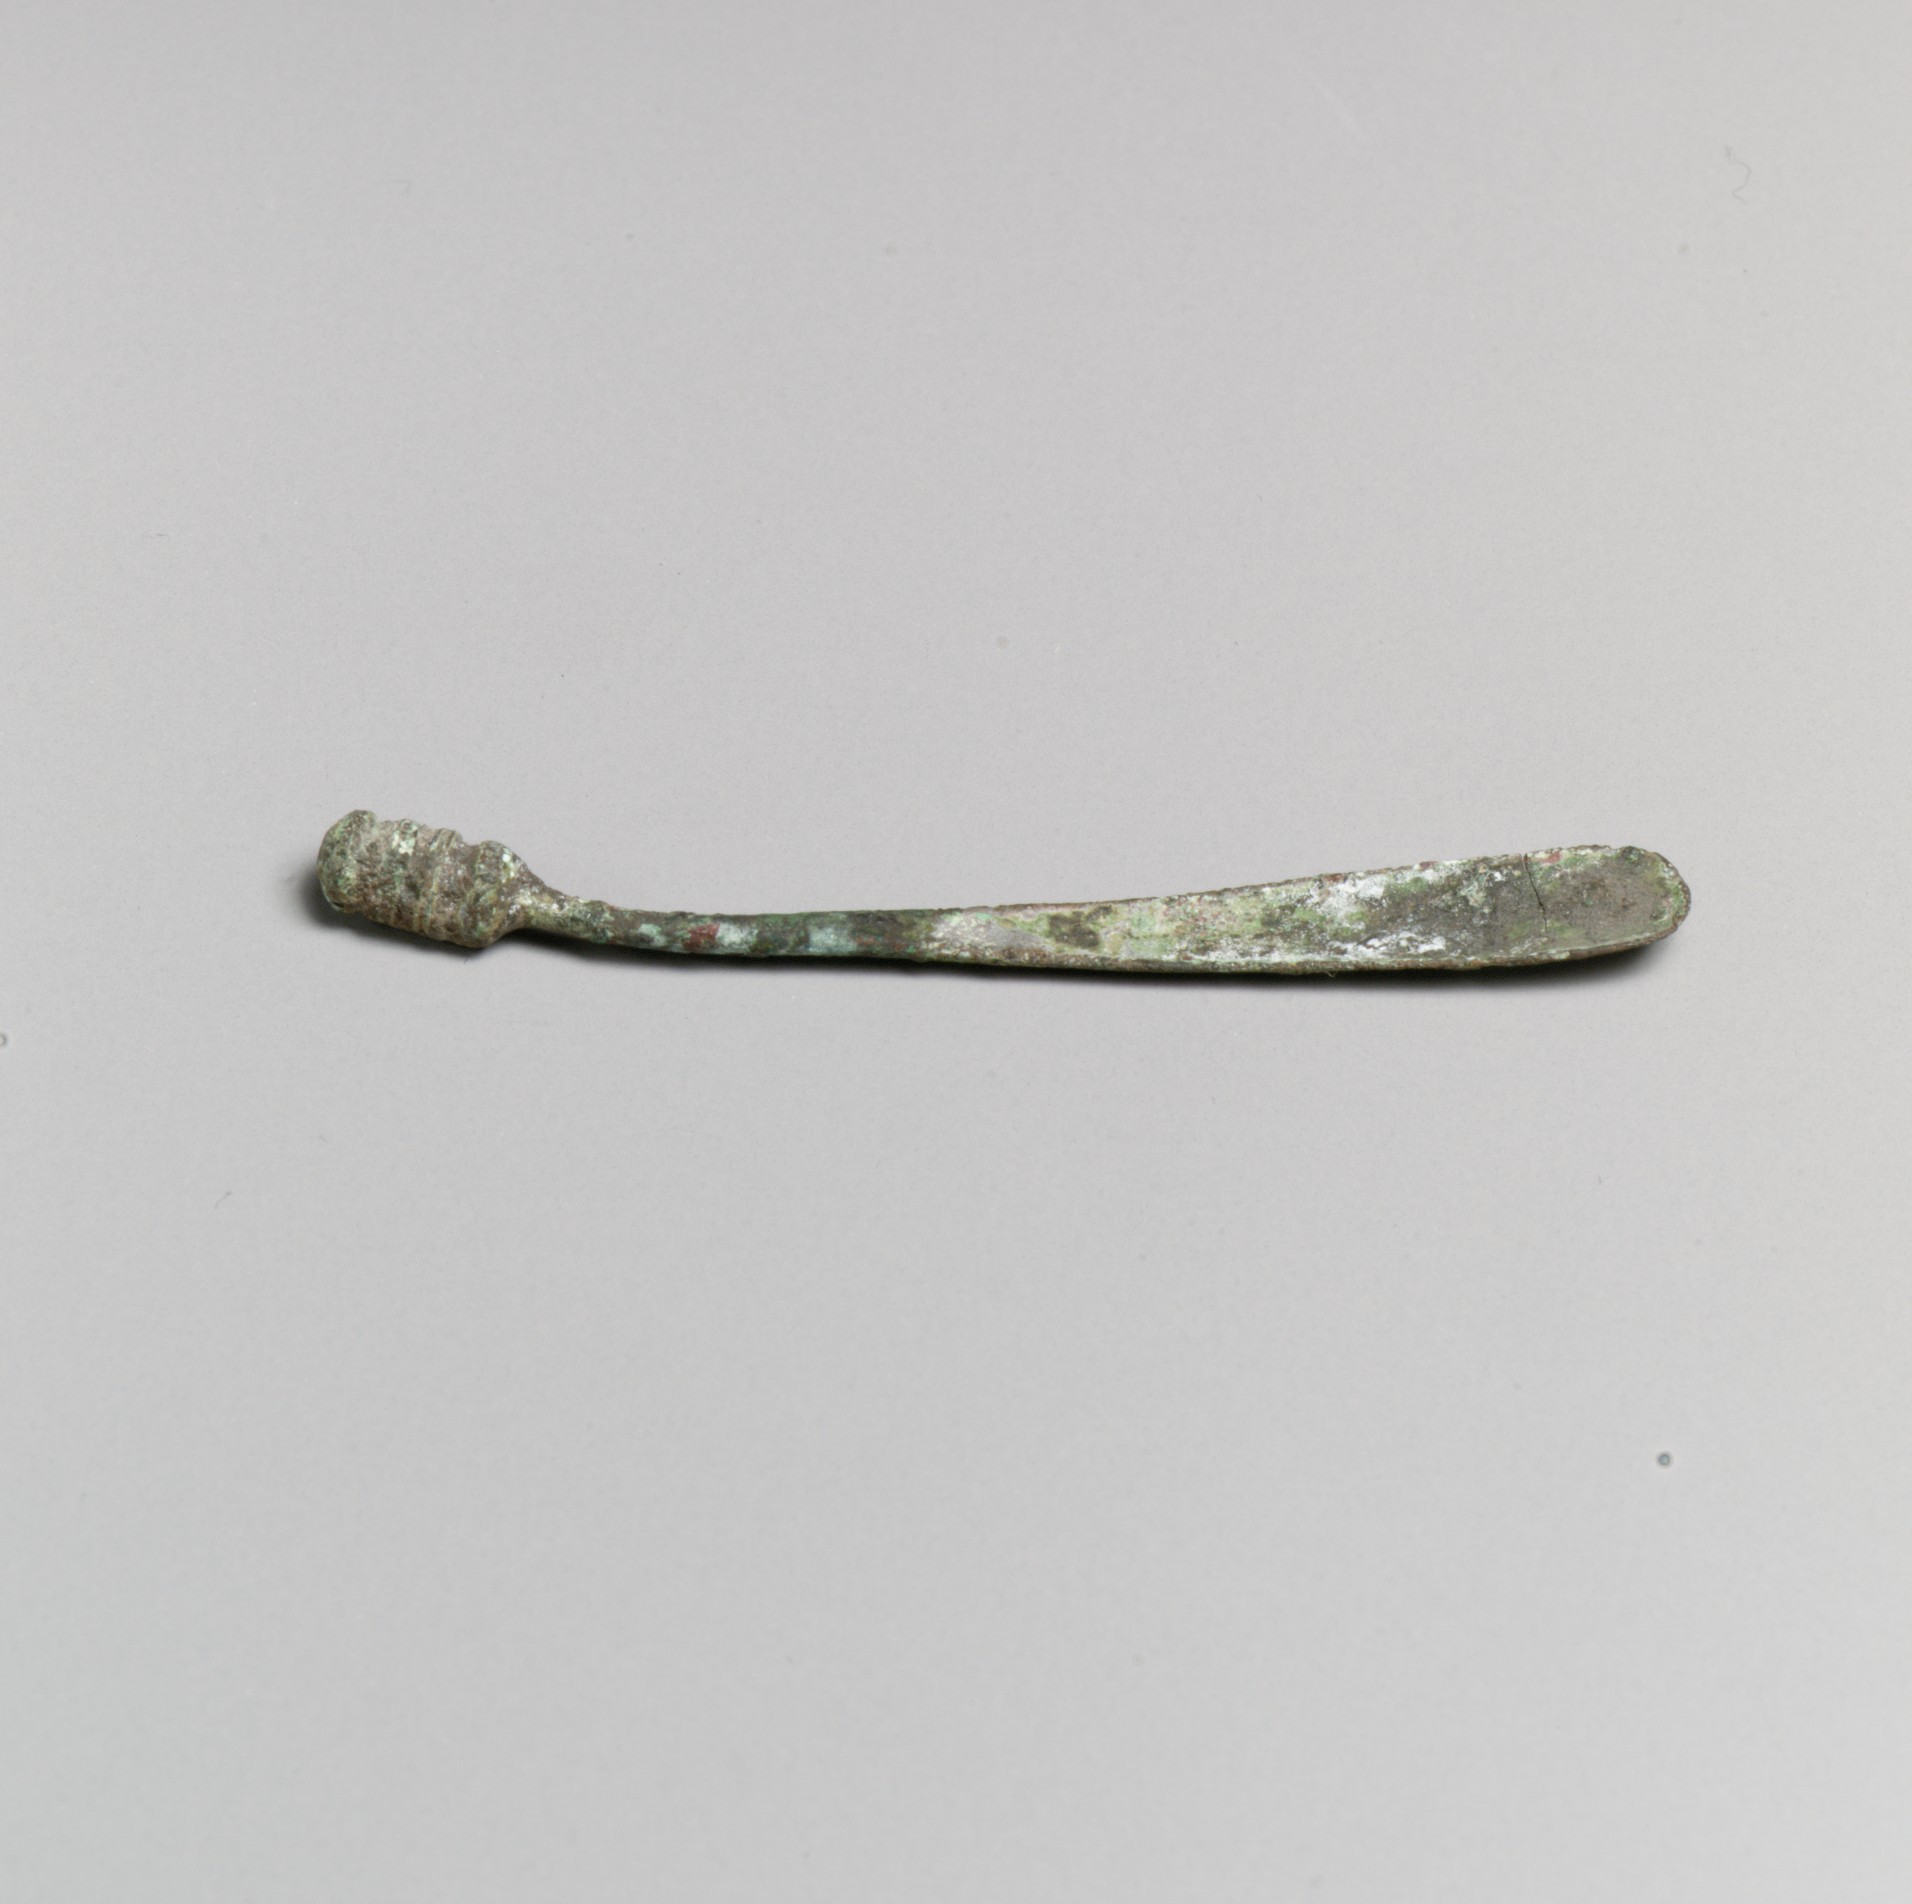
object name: curette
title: Curette ?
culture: roman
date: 670 BCE-330 CE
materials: bronze